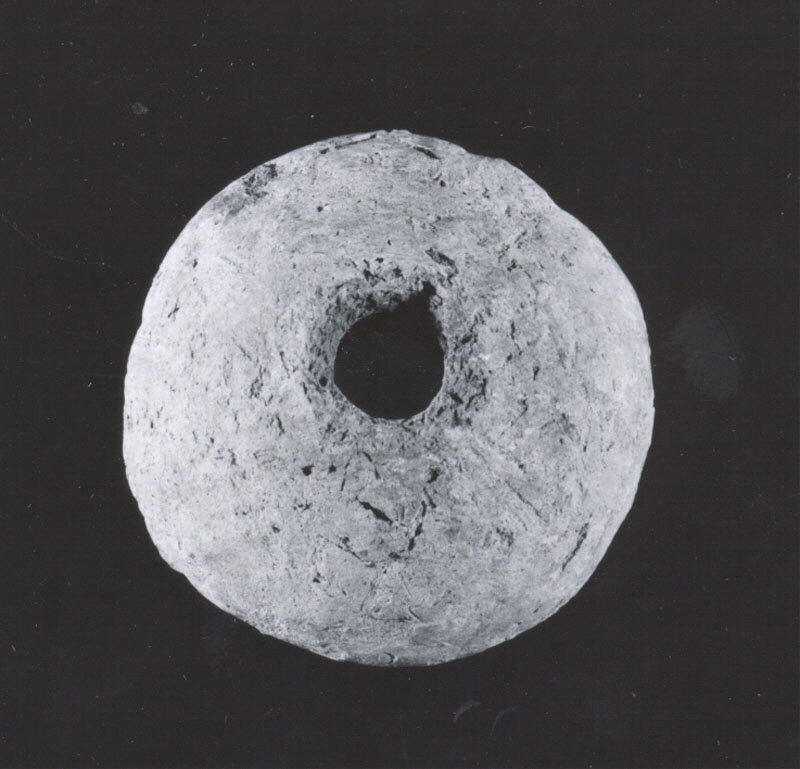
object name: whorl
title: Spindle whorl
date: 4000-3001 BCE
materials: ceramic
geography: iran